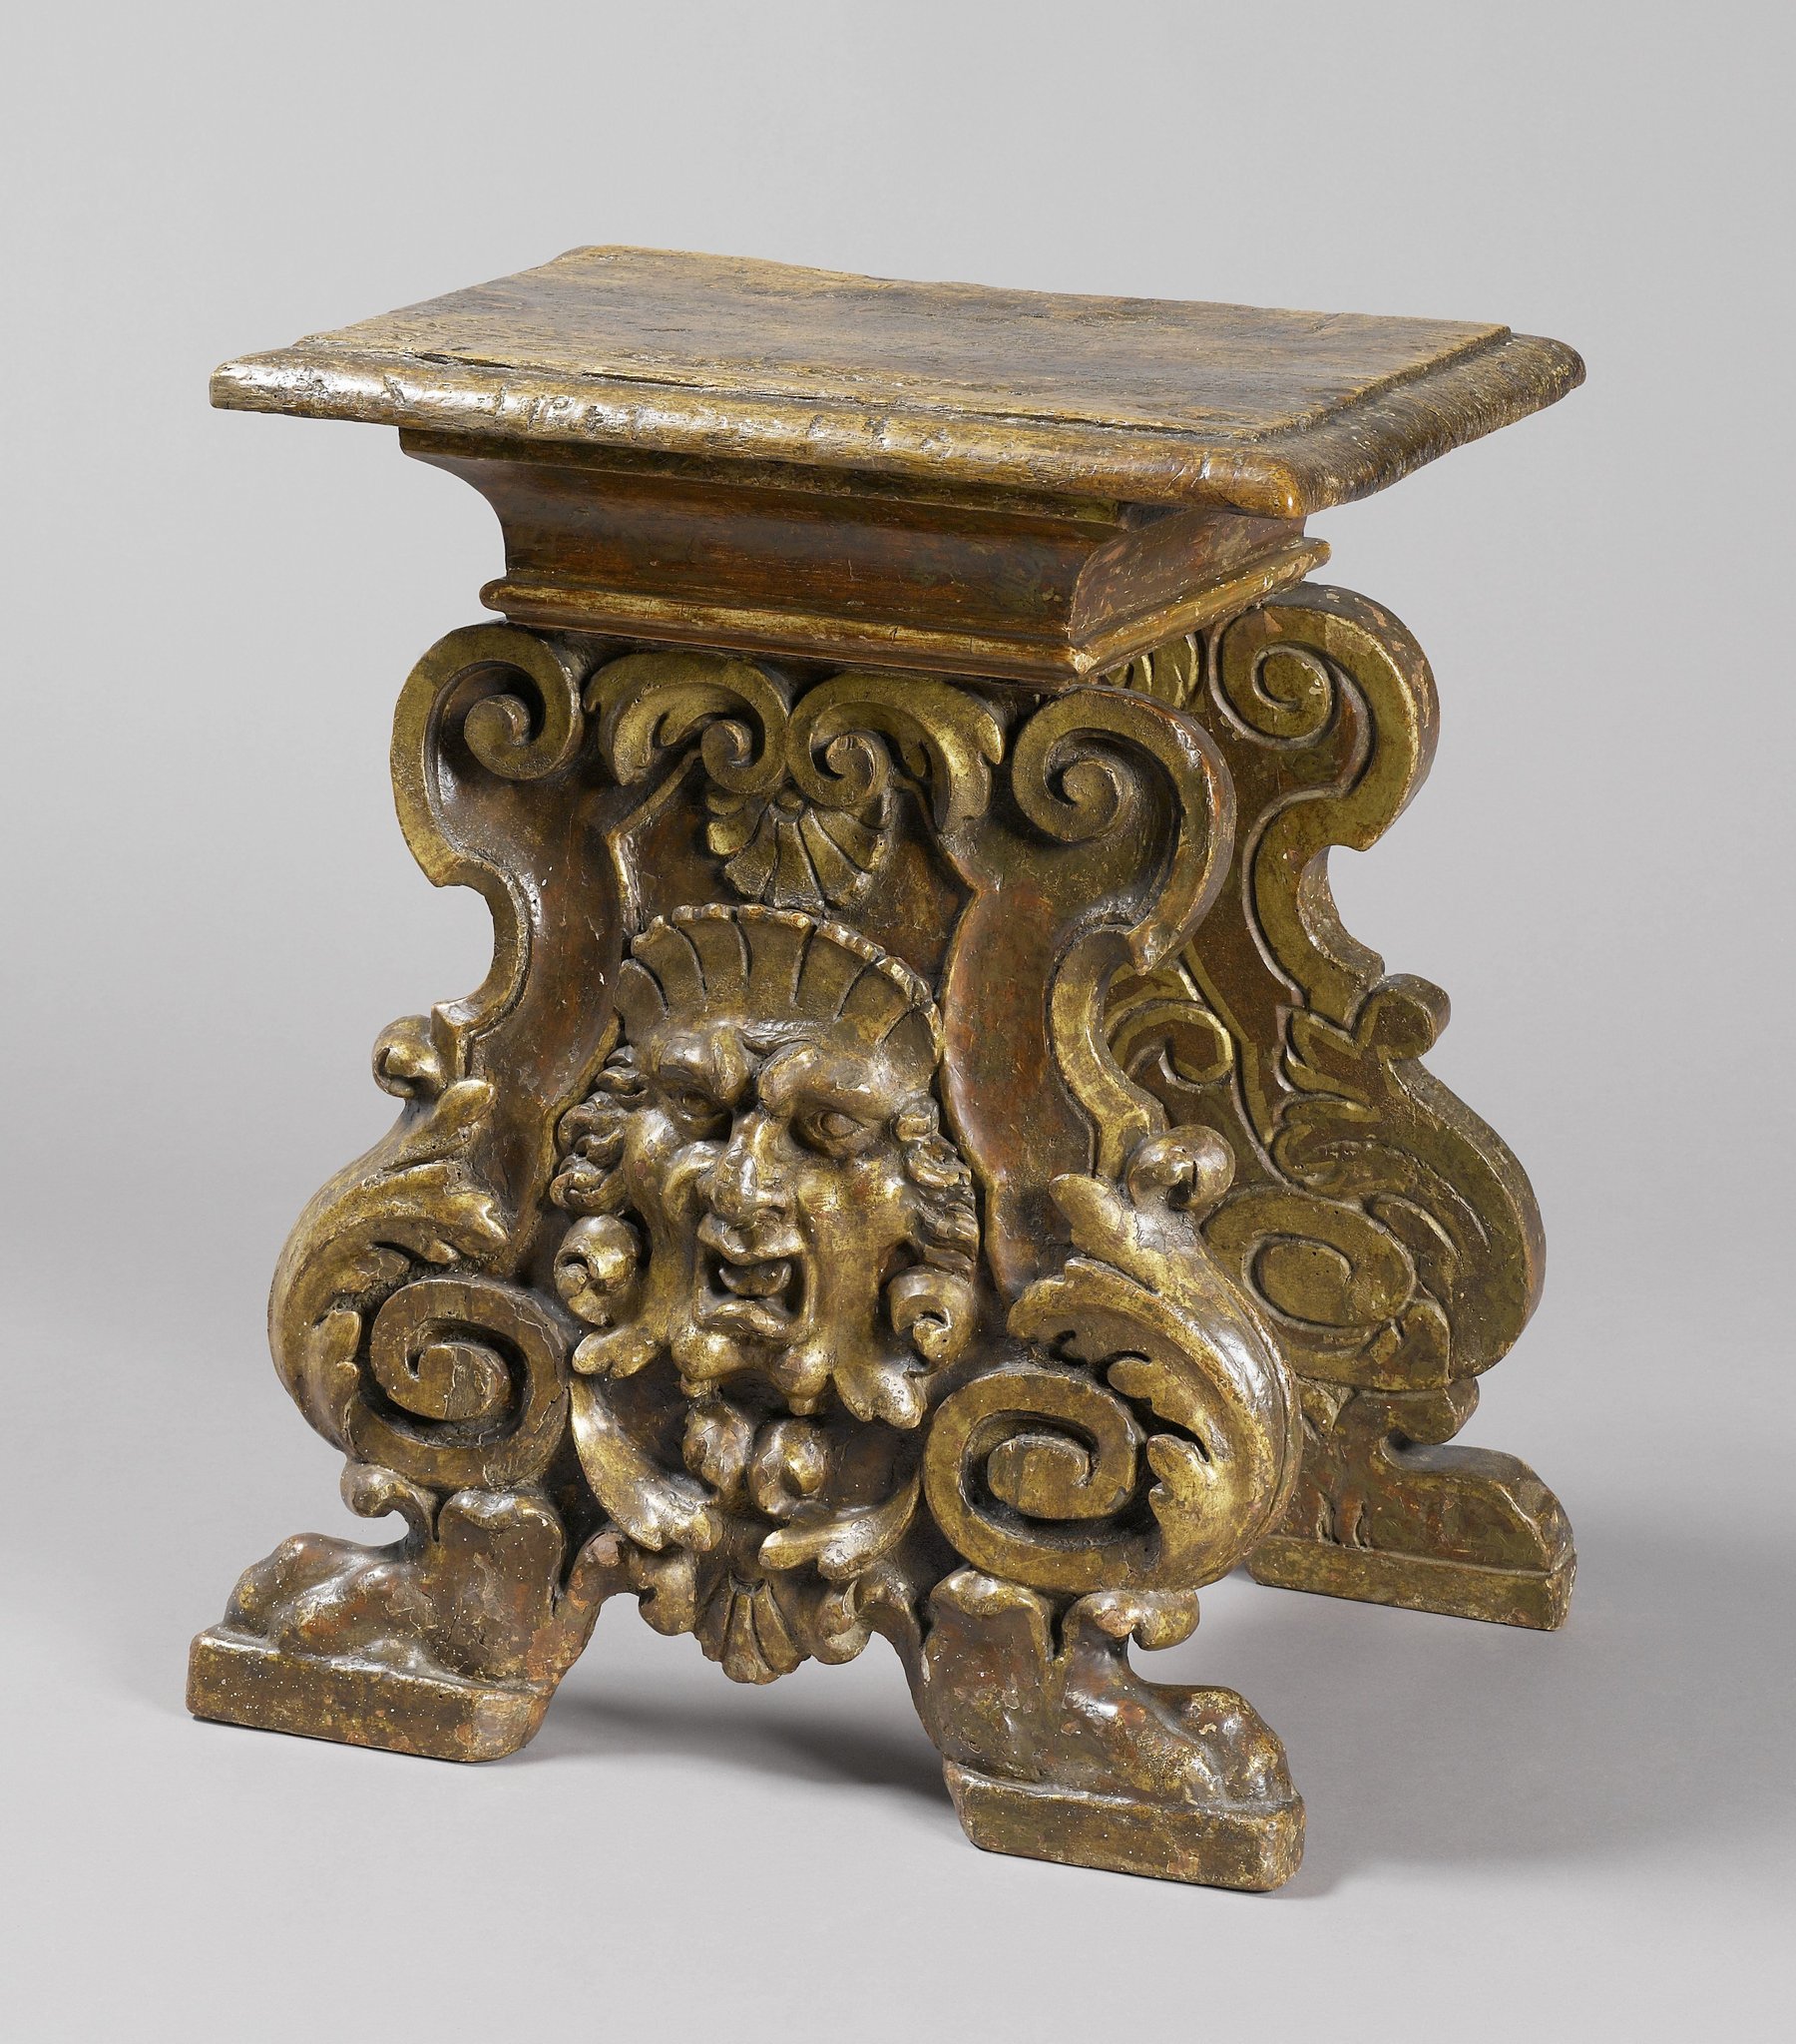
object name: tabouret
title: Taboeret van verguld populierenhout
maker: Anonymous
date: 1500-1600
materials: paint, wood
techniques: gilding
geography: italy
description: Stool. Poplar, gilded. Italy, 16th century. J.M. Edwin vom Rath bequest, 1941.